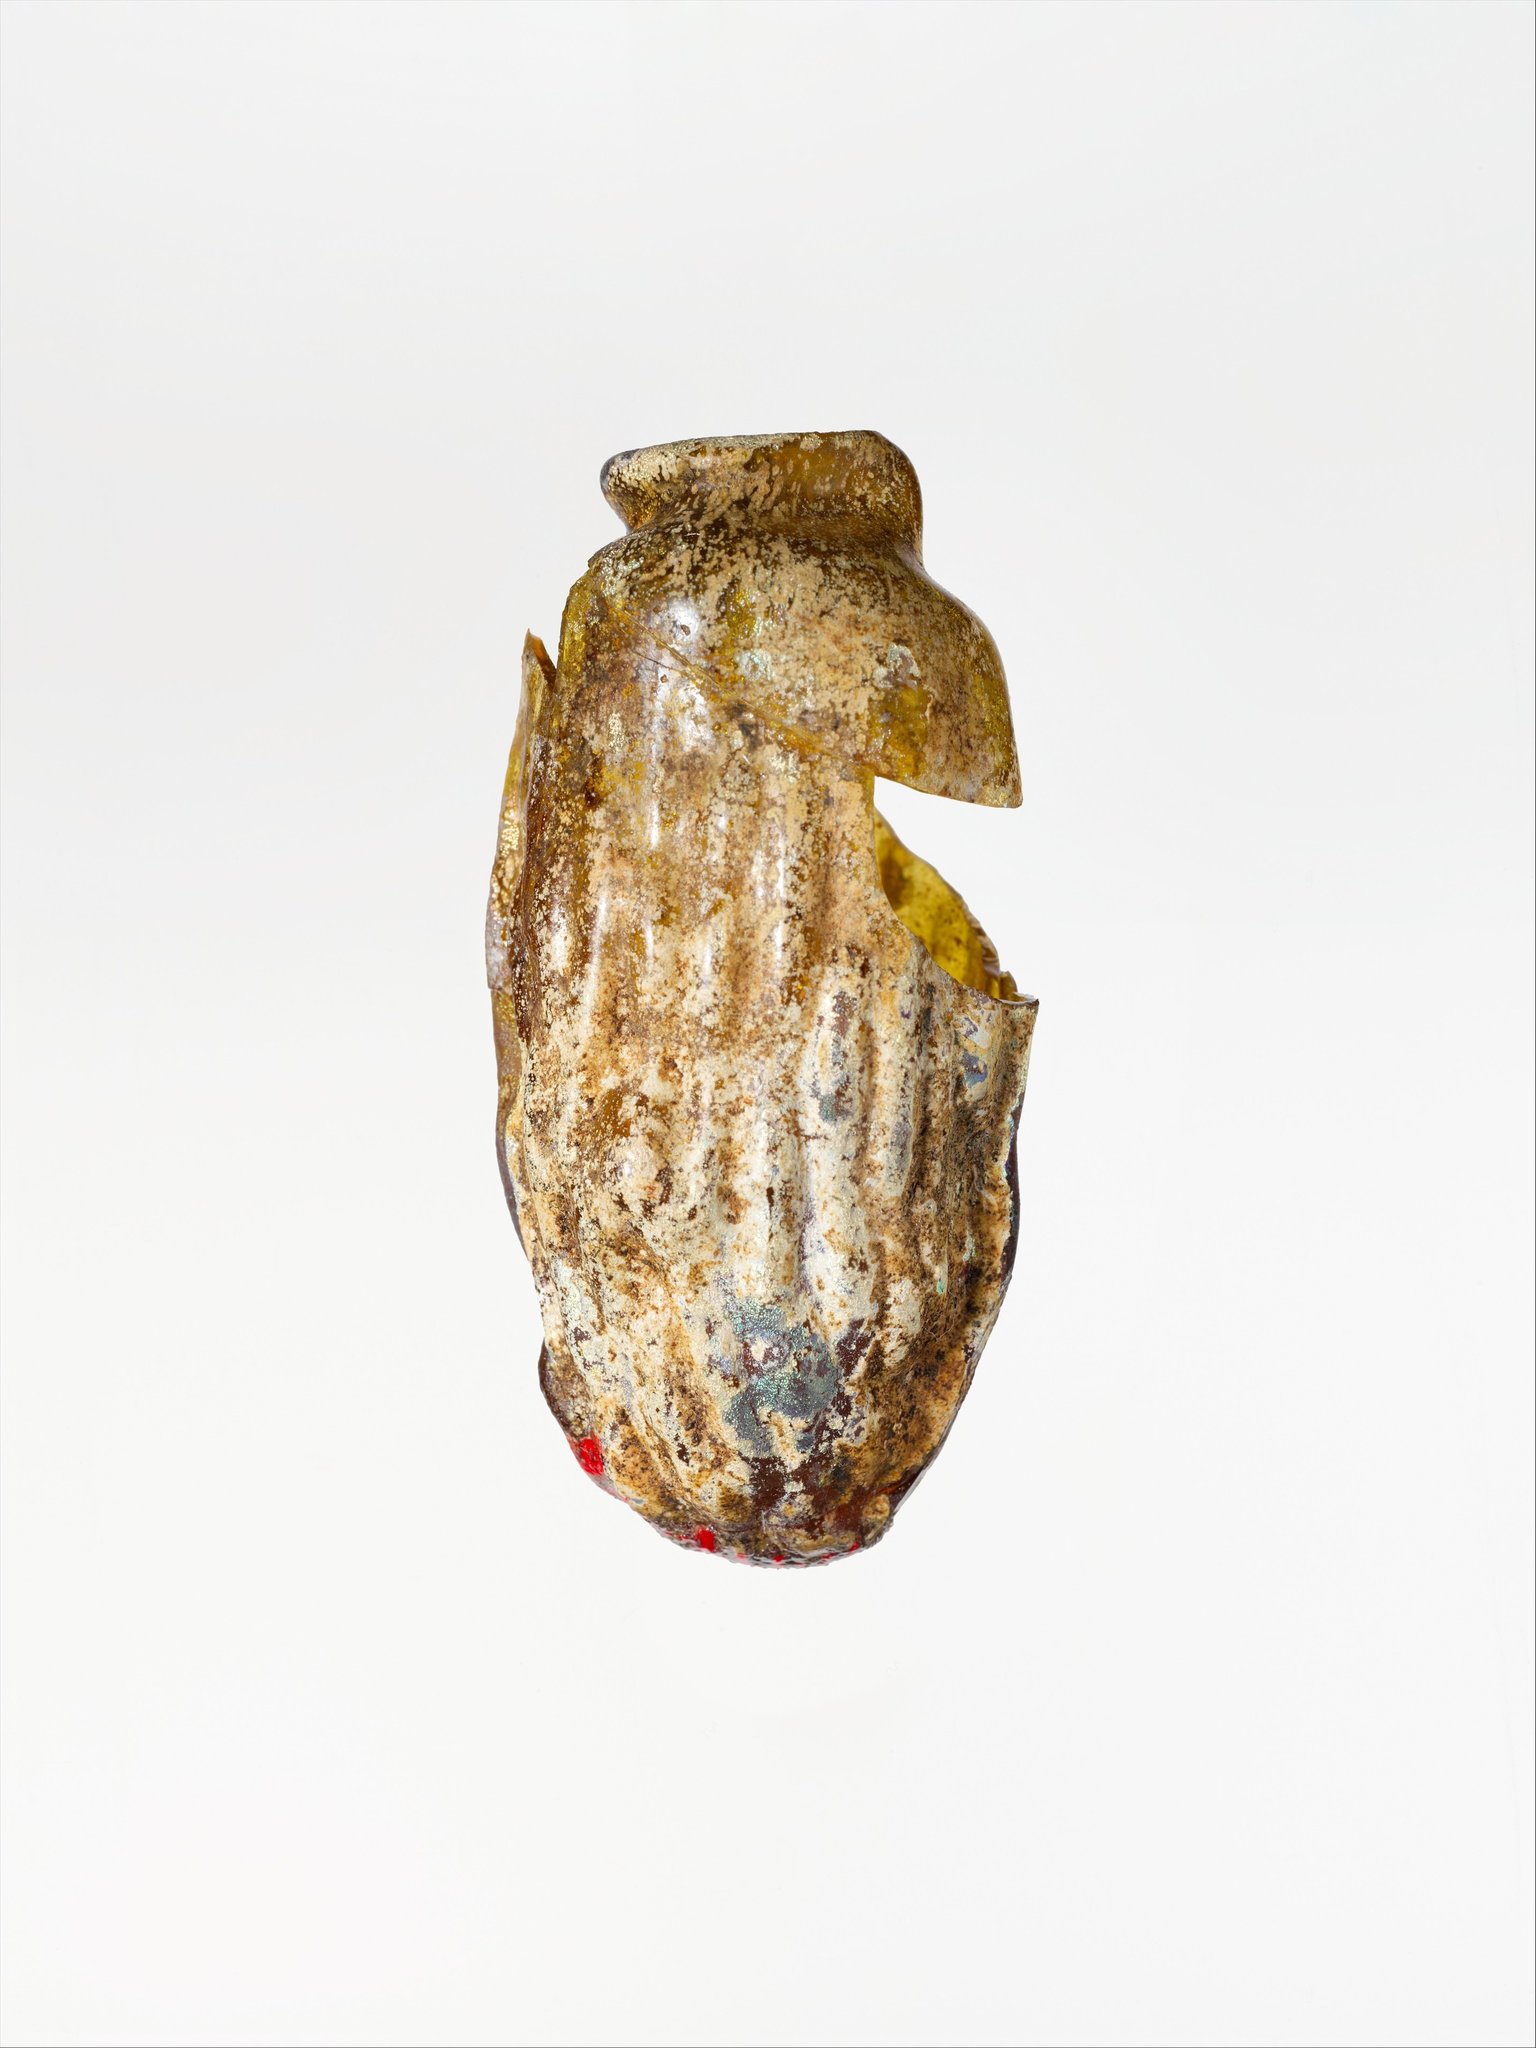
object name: flask in the form of a date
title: Glass bottle shaped like a date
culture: roman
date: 34-133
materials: glass